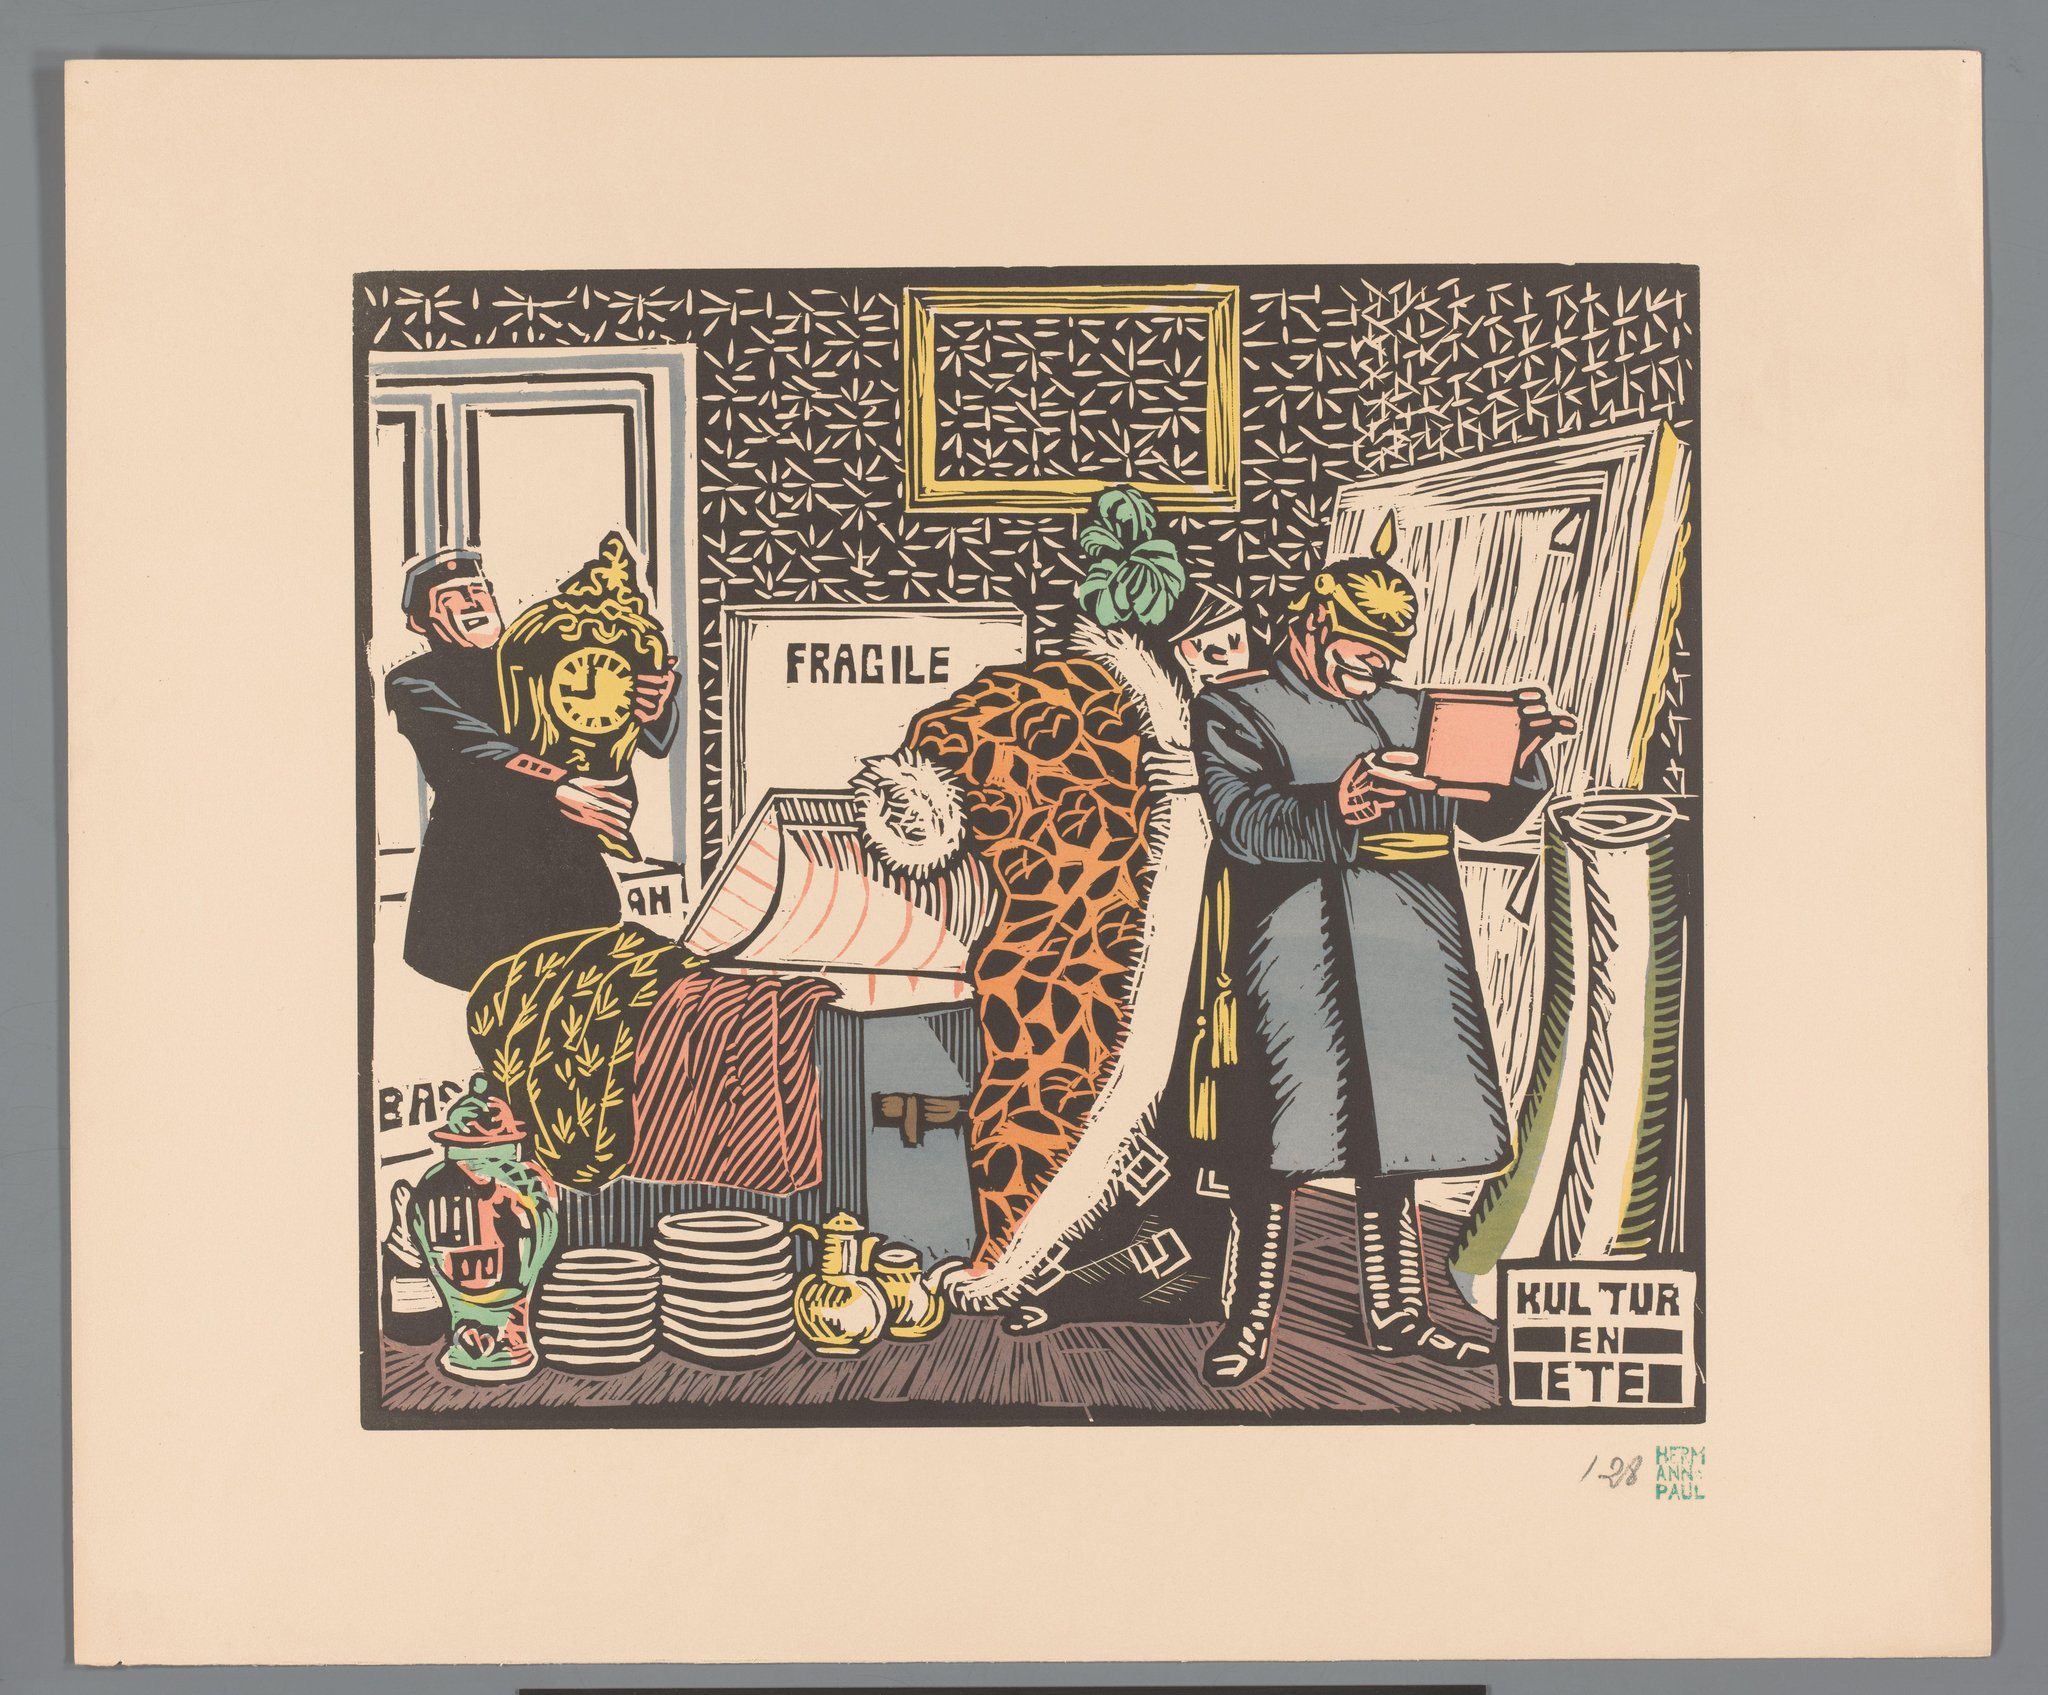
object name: print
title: Soldaten plunderen een huis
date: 1915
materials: paper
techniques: woodcut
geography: paris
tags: plundering ~ soldiers, interior of the house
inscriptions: collector's mark: Lugt 2233, workshop stamp: ‘Hermann: Paul’